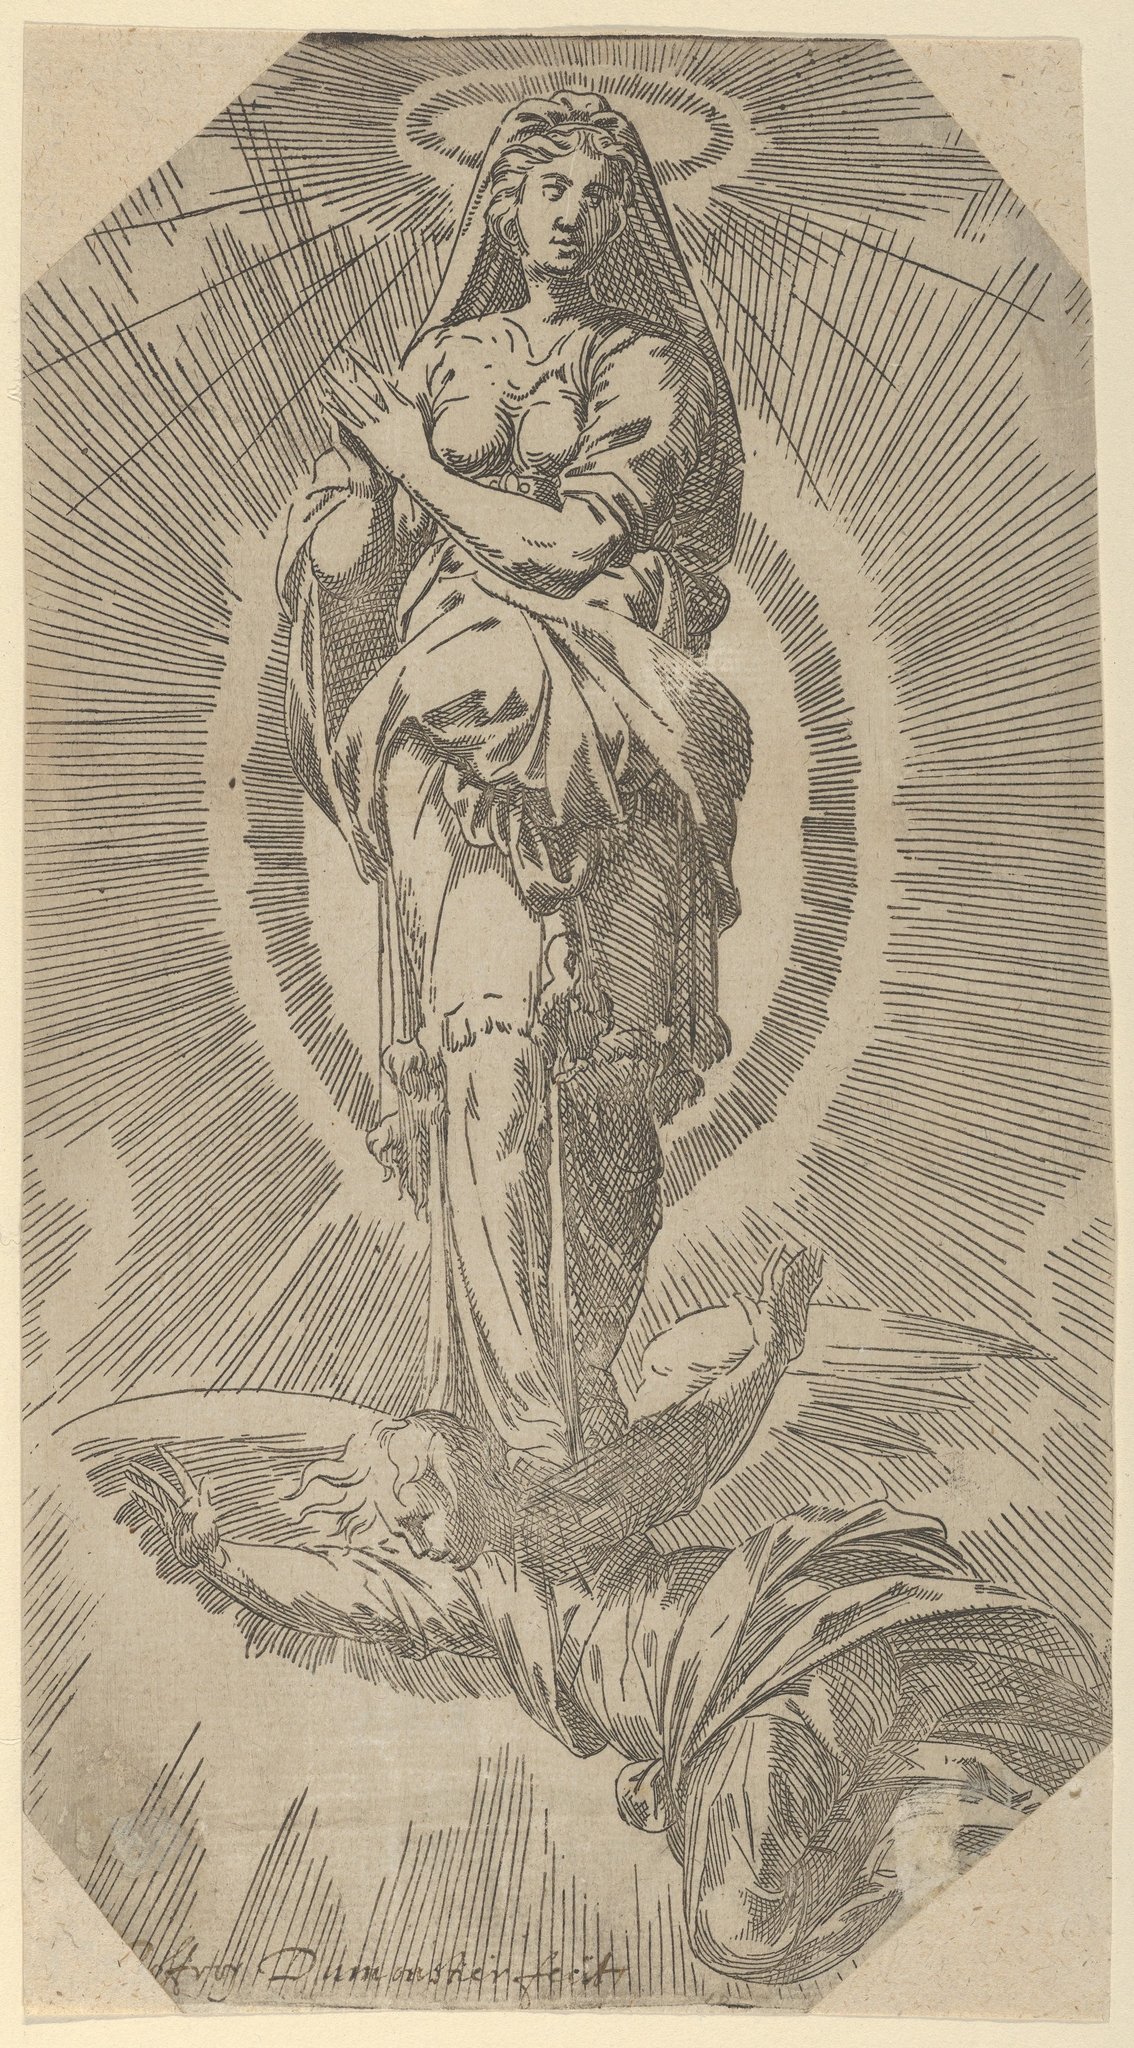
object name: print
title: The Assumption of the Virgin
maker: geoffroy dumoûtier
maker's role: artist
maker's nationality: french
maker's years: 1530-1578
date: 1535-1573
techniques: etching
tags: virgin mary,assumption of the virgin